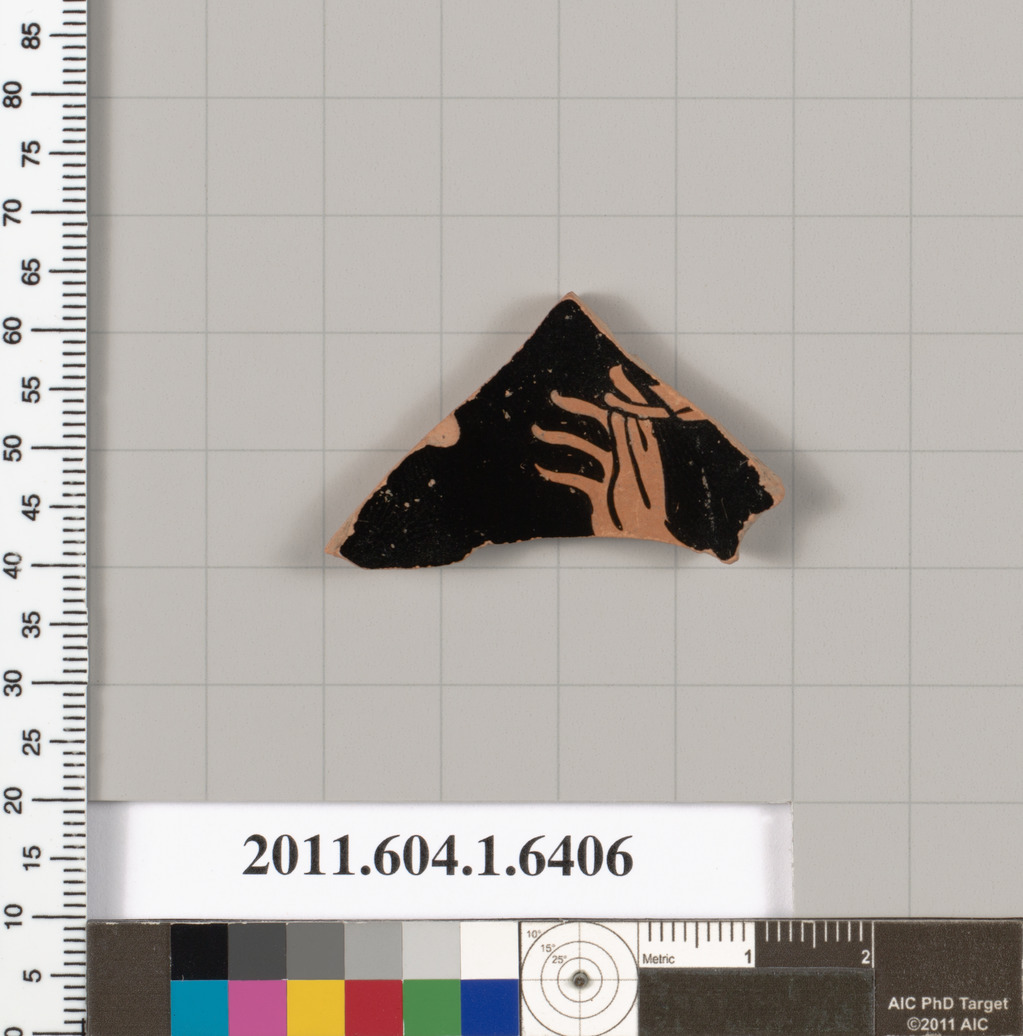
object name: kylix fragment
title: Terracotta fragment of a kylix (drinking cup)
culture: greek, attic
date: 490-480 BCE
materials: terracotta